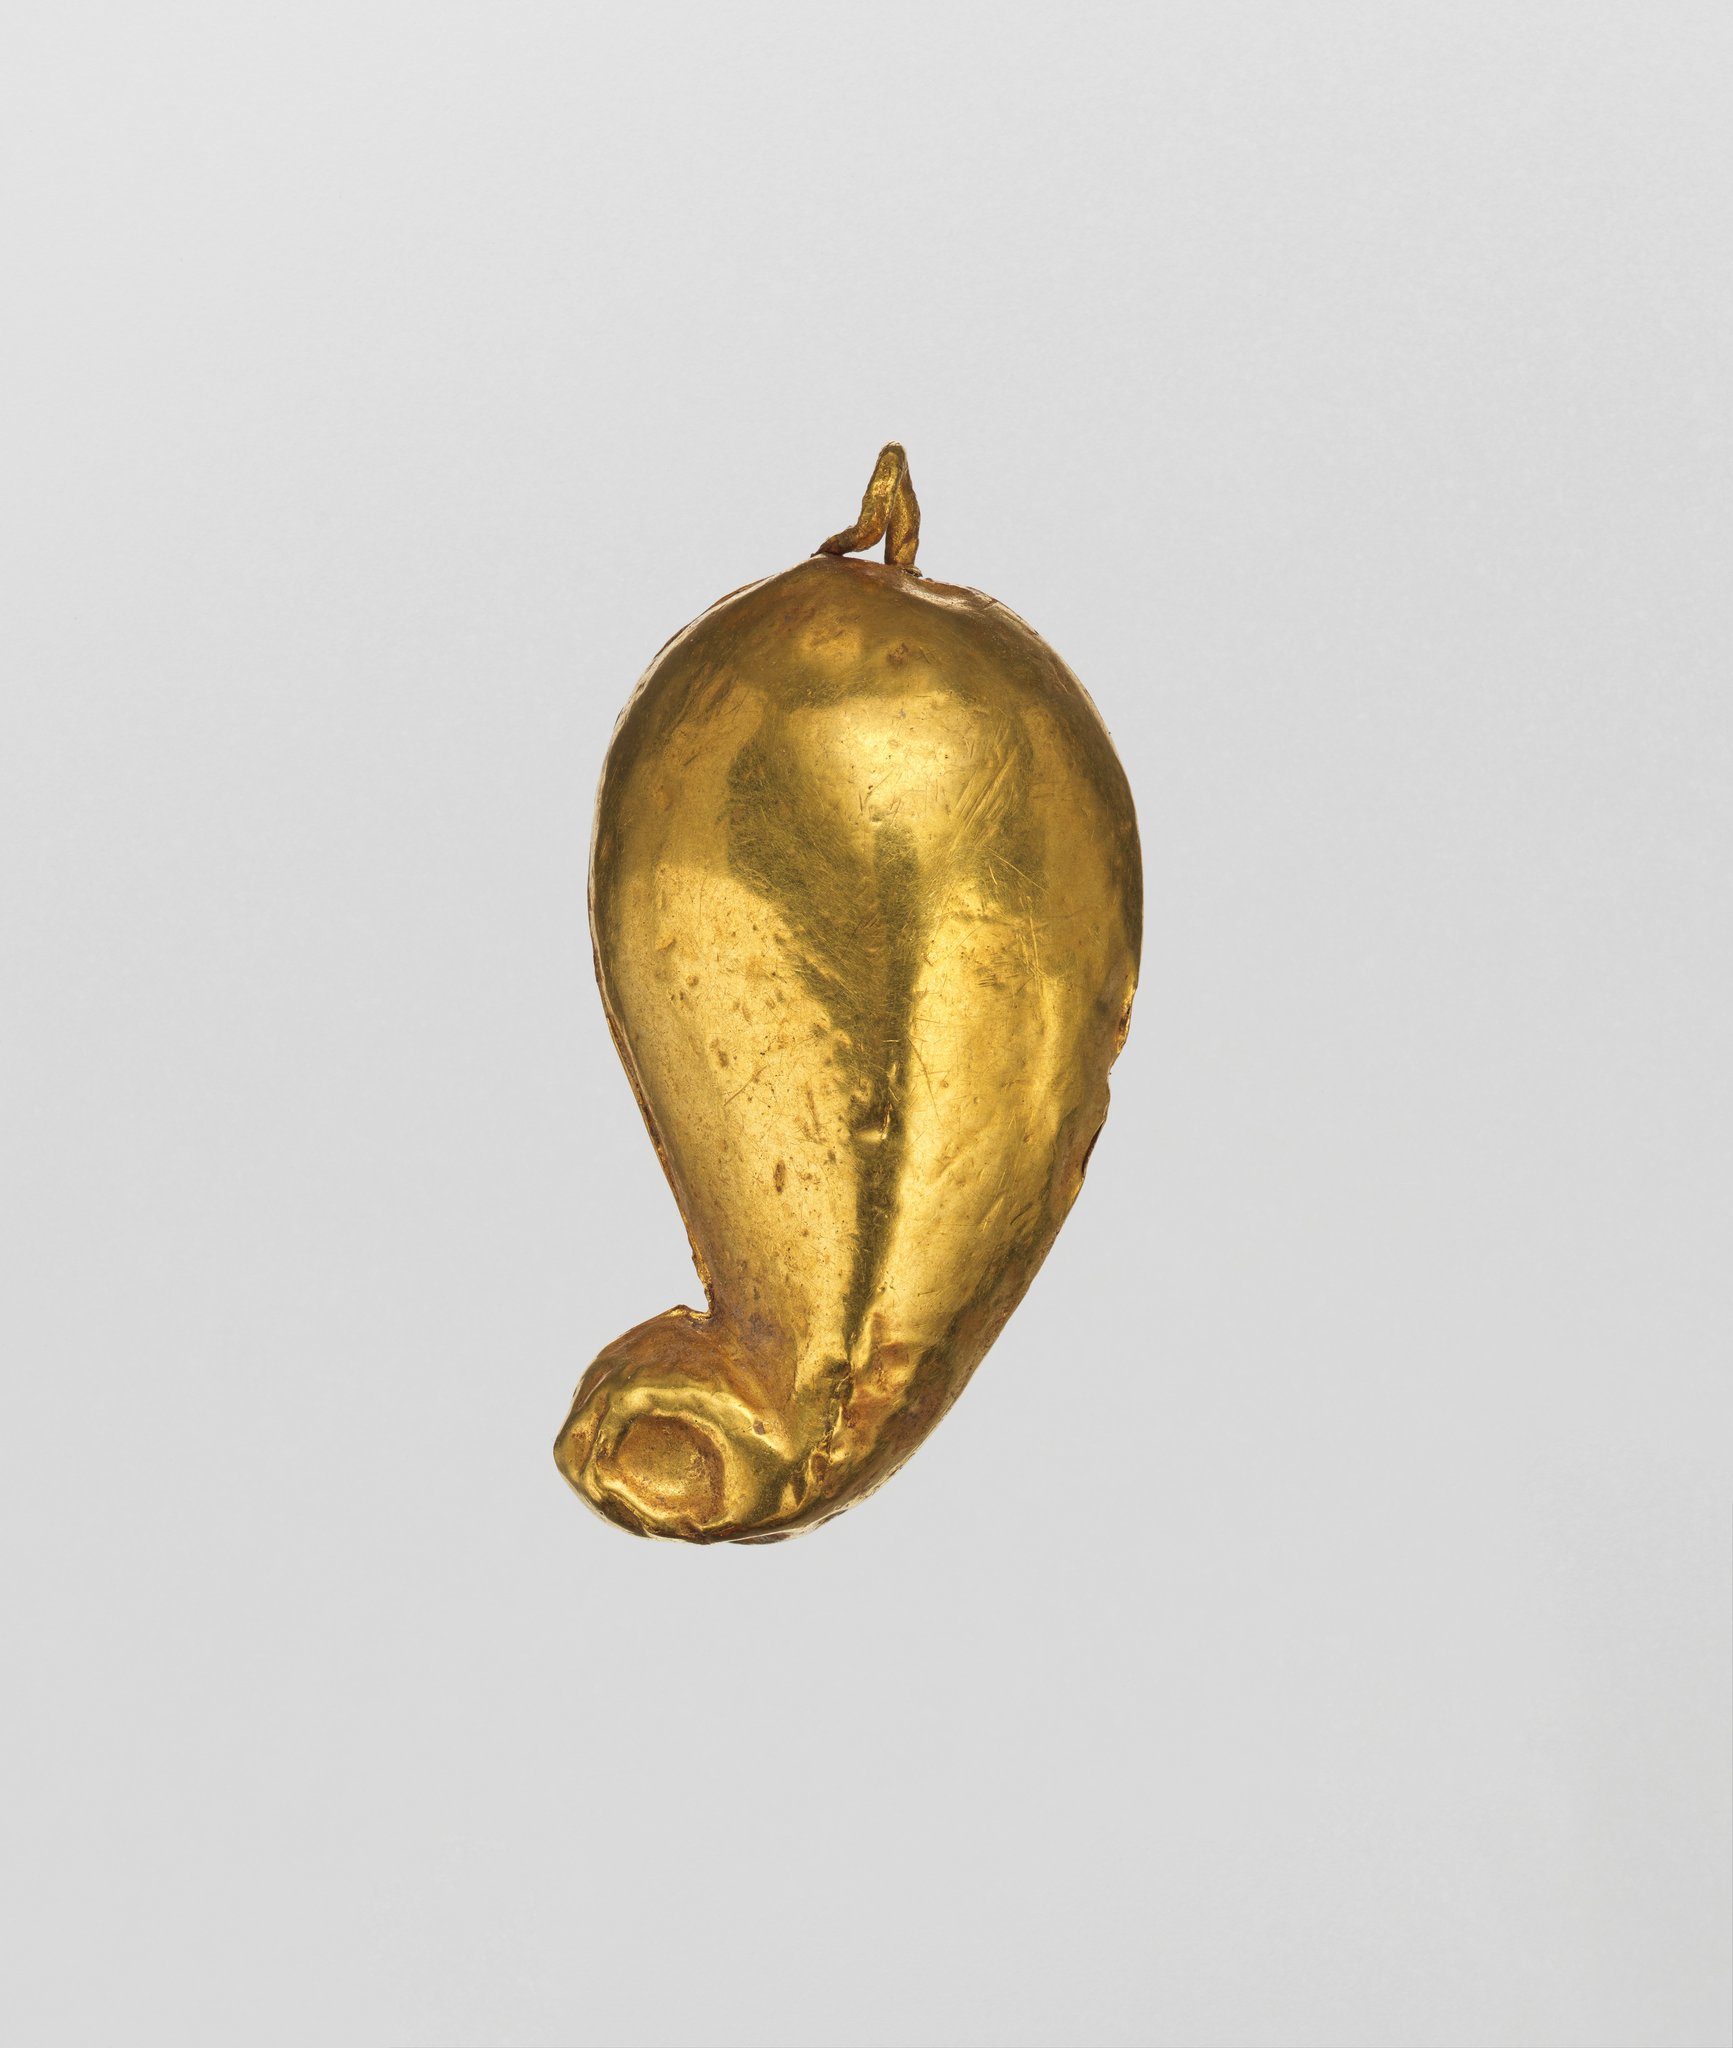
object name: amulet pendant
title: Pendant amulet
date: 332-330 BCE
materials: gold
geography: egypt